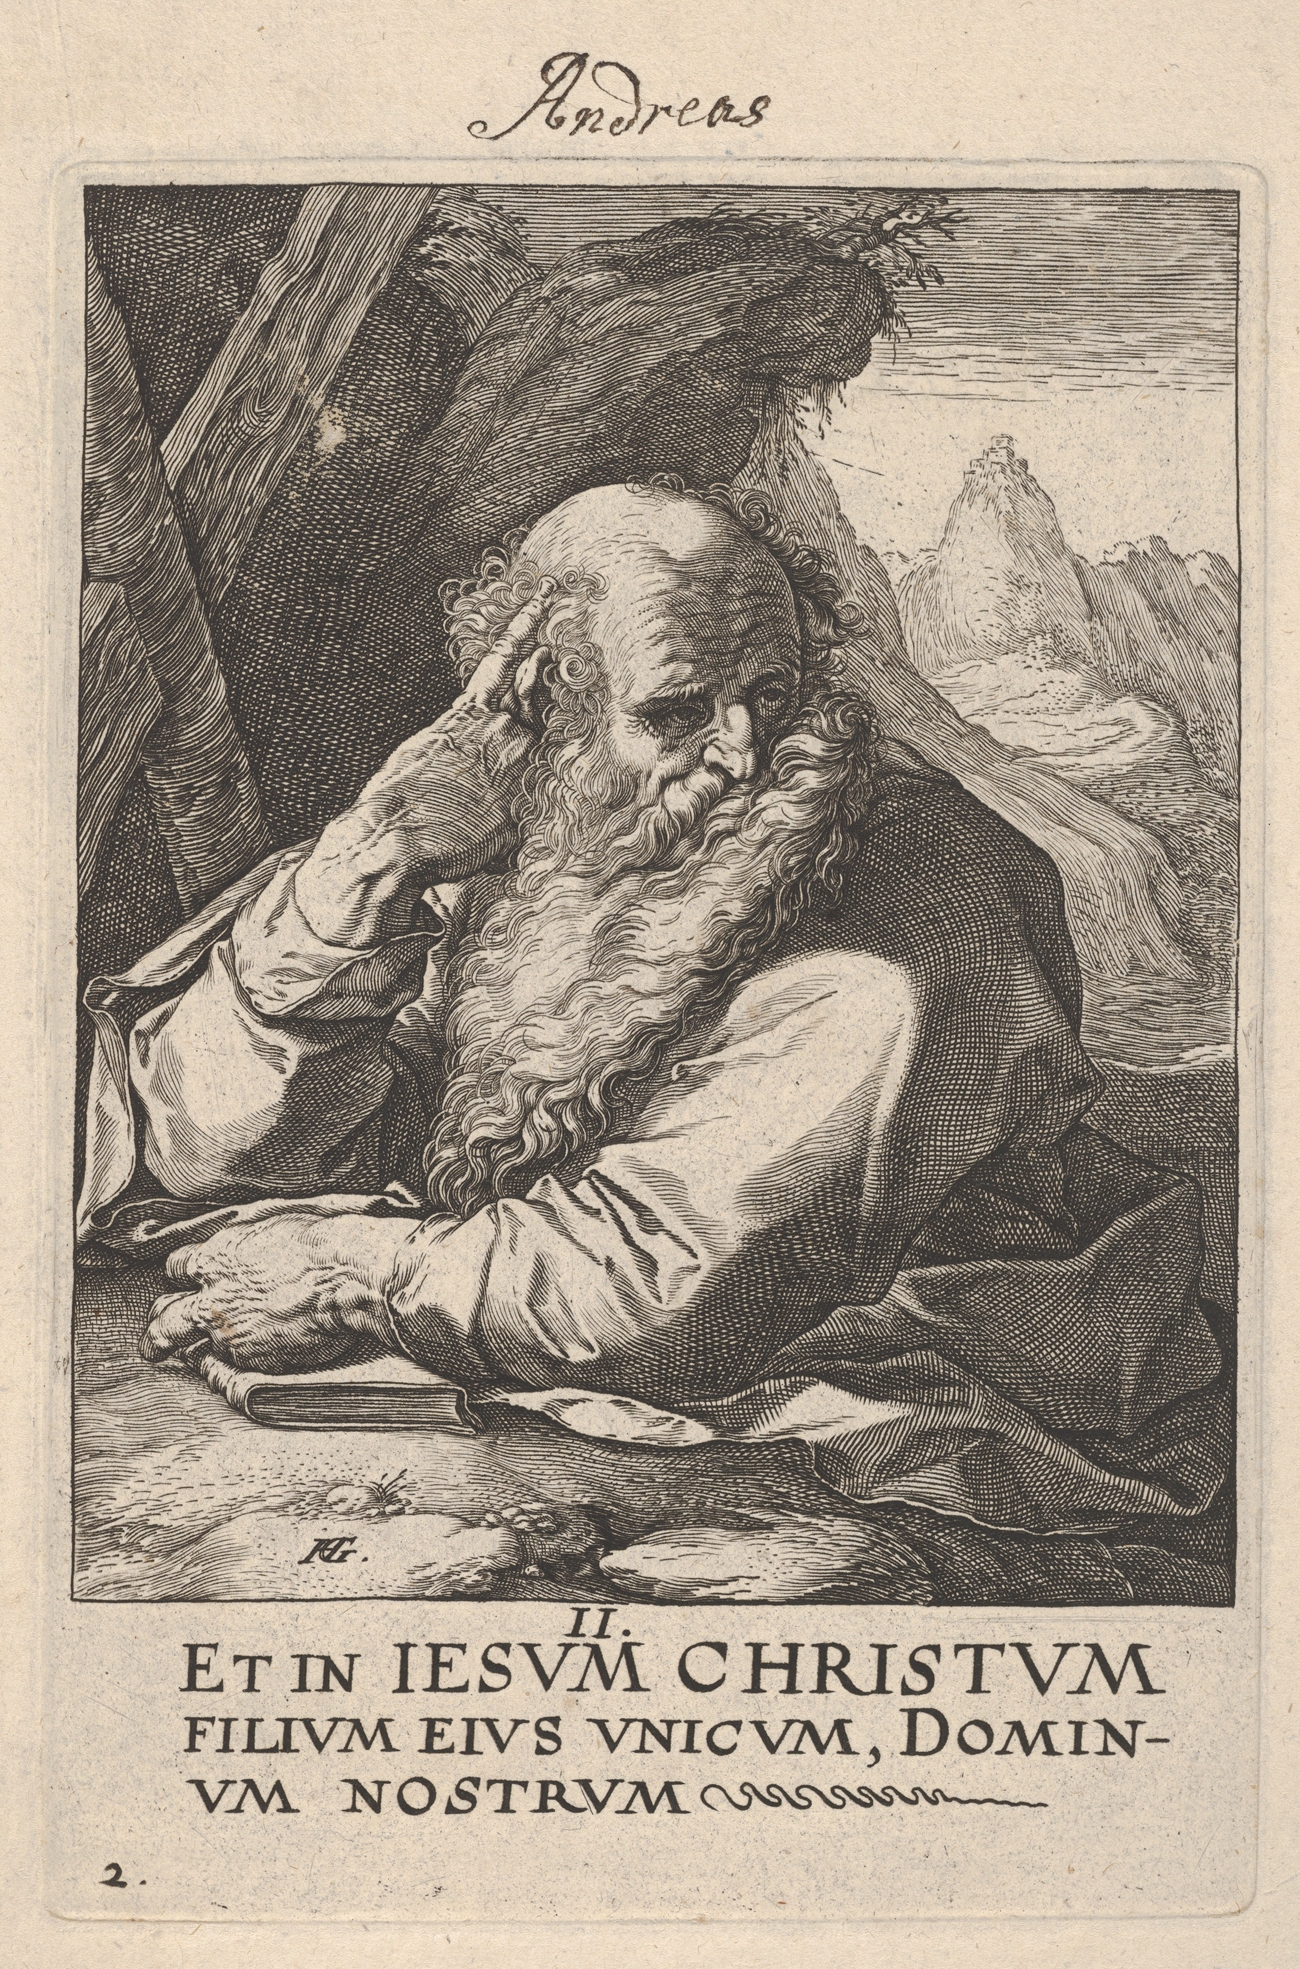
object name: print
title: St. Andrew, from "Christ, the Apostles and St. Paul with the Creed"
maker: hendrick goltzius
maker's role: artist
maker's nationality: netherlandish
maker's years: 1558-1617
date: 1589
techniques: engraving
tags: portraits,apostles,saints